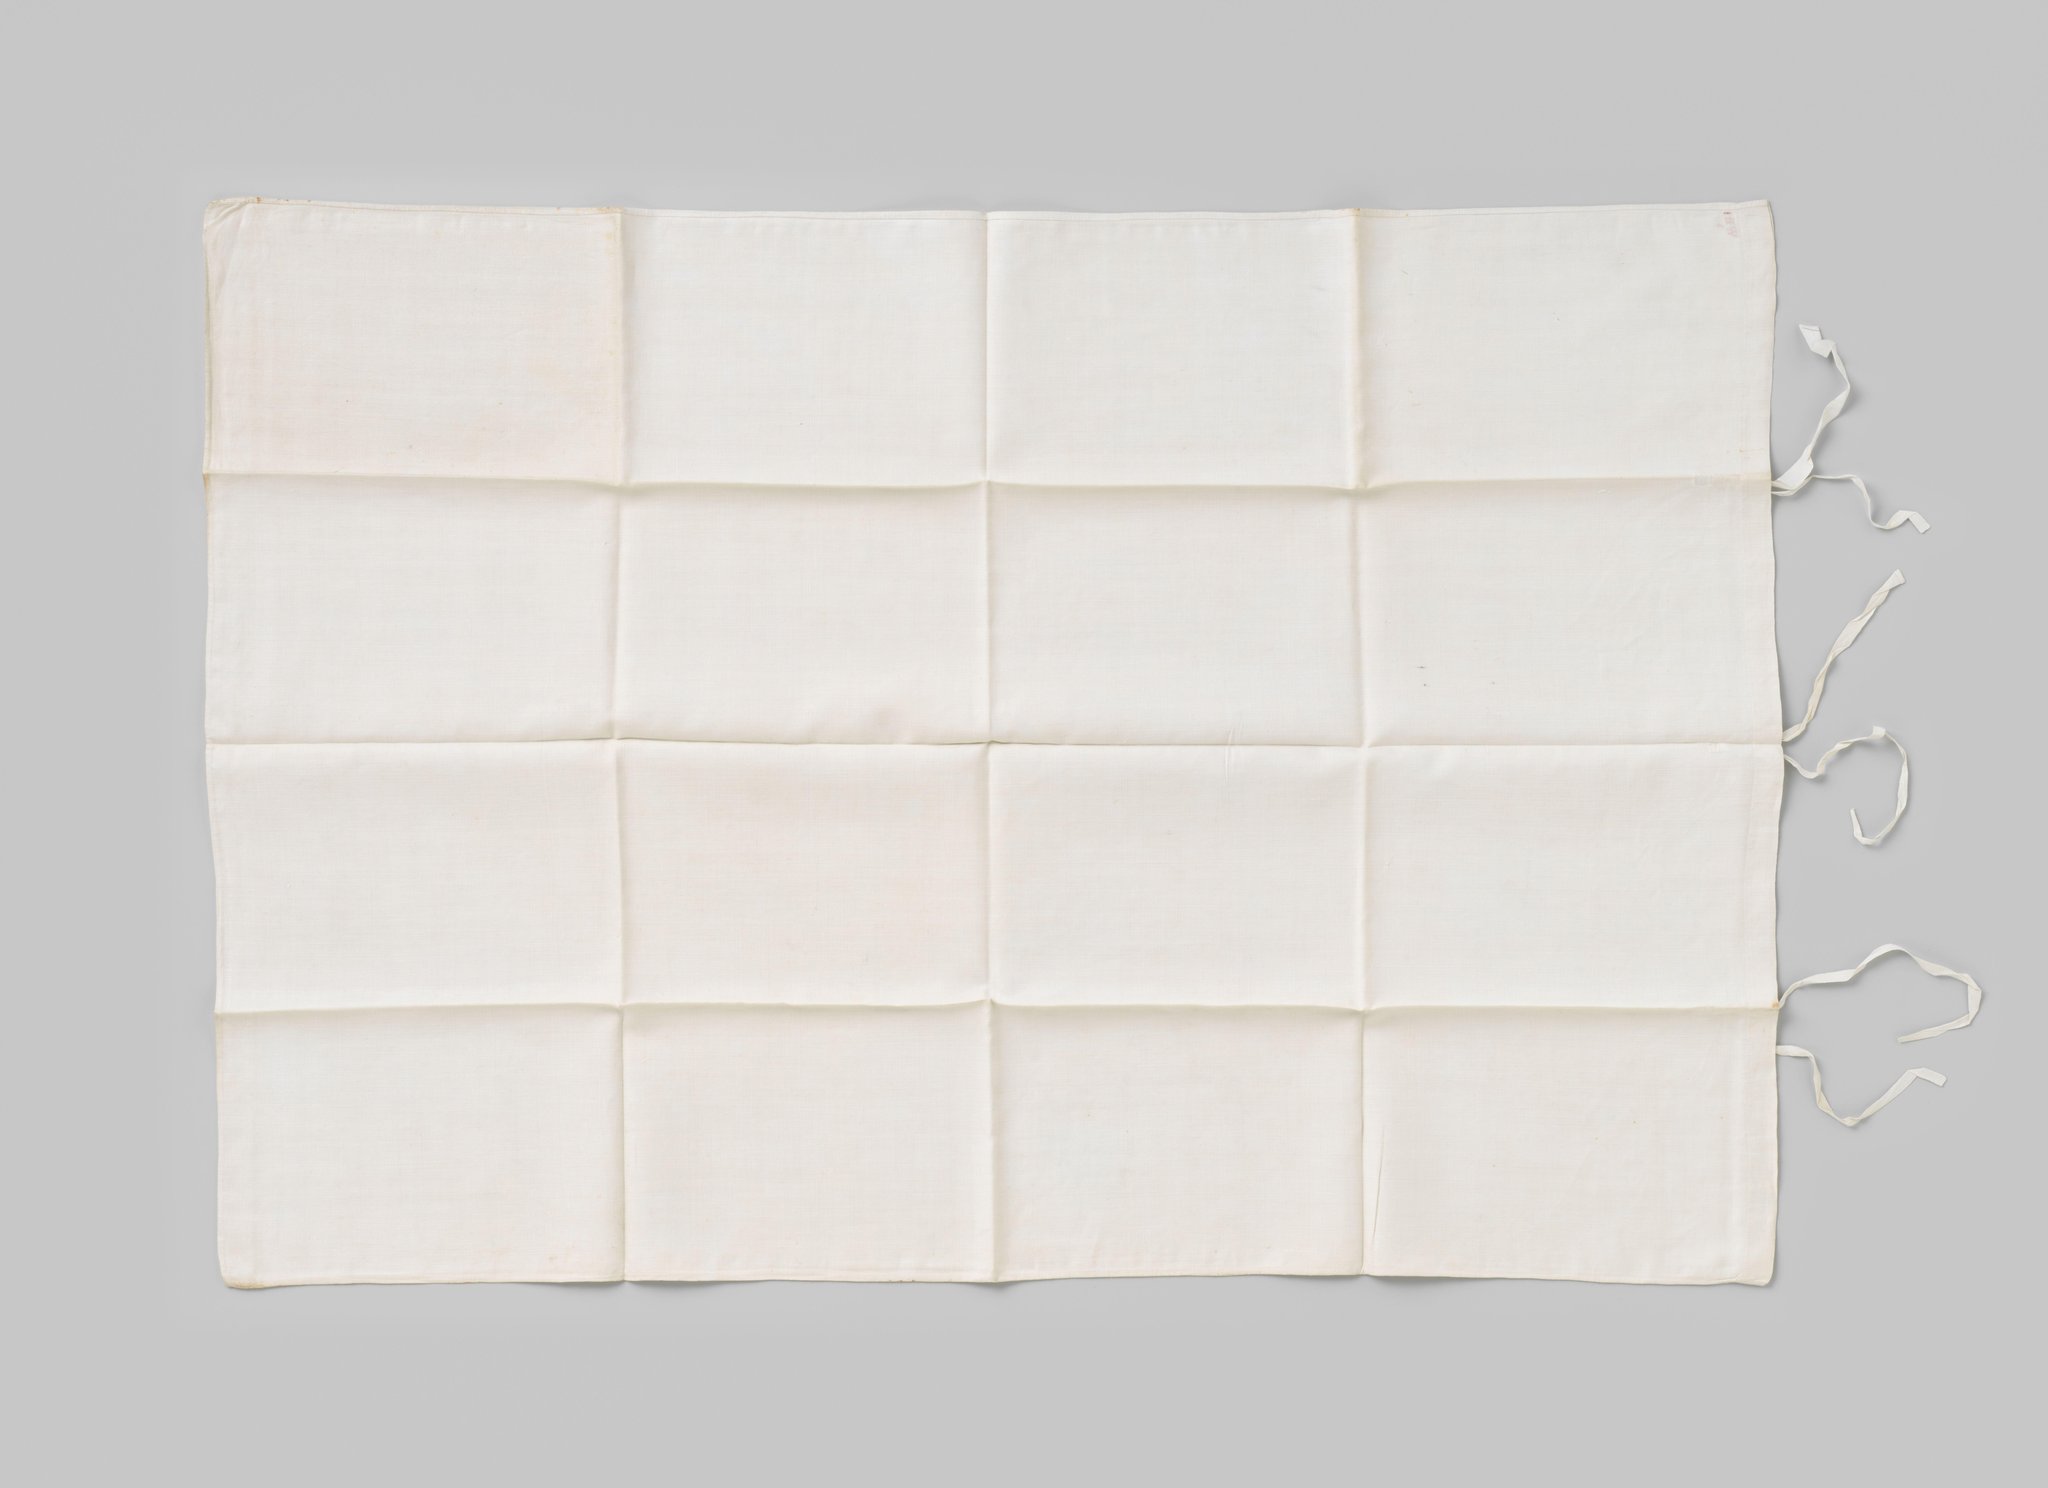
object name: sloop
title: Sloop van linnen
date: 1820-1870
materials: linen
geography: northern netherlands